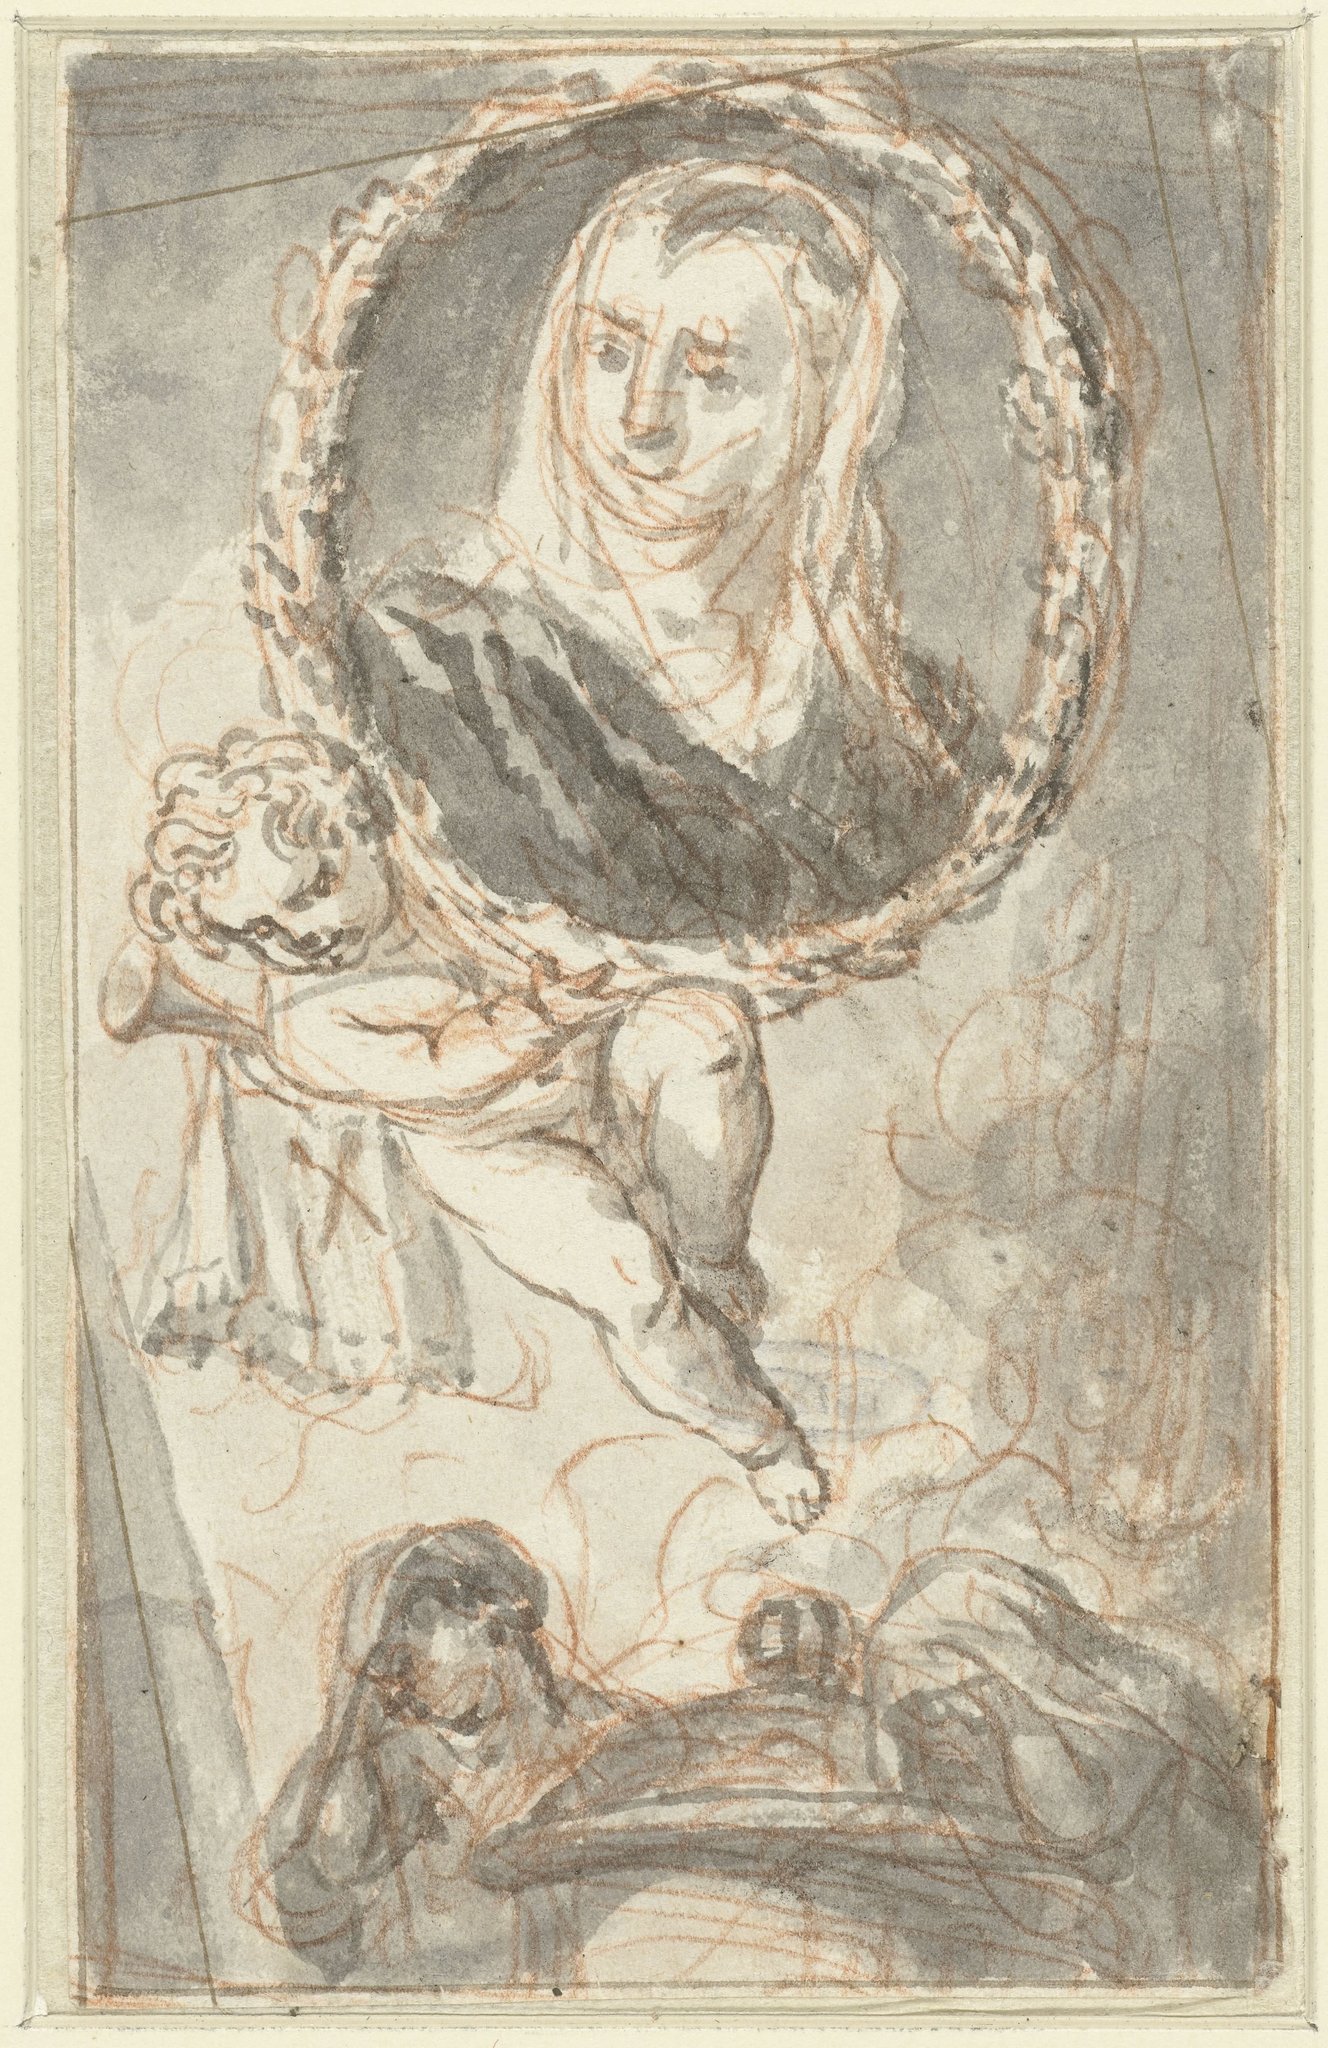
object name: drawing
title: Portret van Johanna Koerten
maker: jacob houbraken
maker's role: draughtsman, print maker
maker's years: 1698-1780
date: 1708-1780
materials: chalk, paper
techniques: brush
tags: amsterdam, draughtsman, johanna koerten, historical persons - bb - woman, portrait, self-portrait of artist